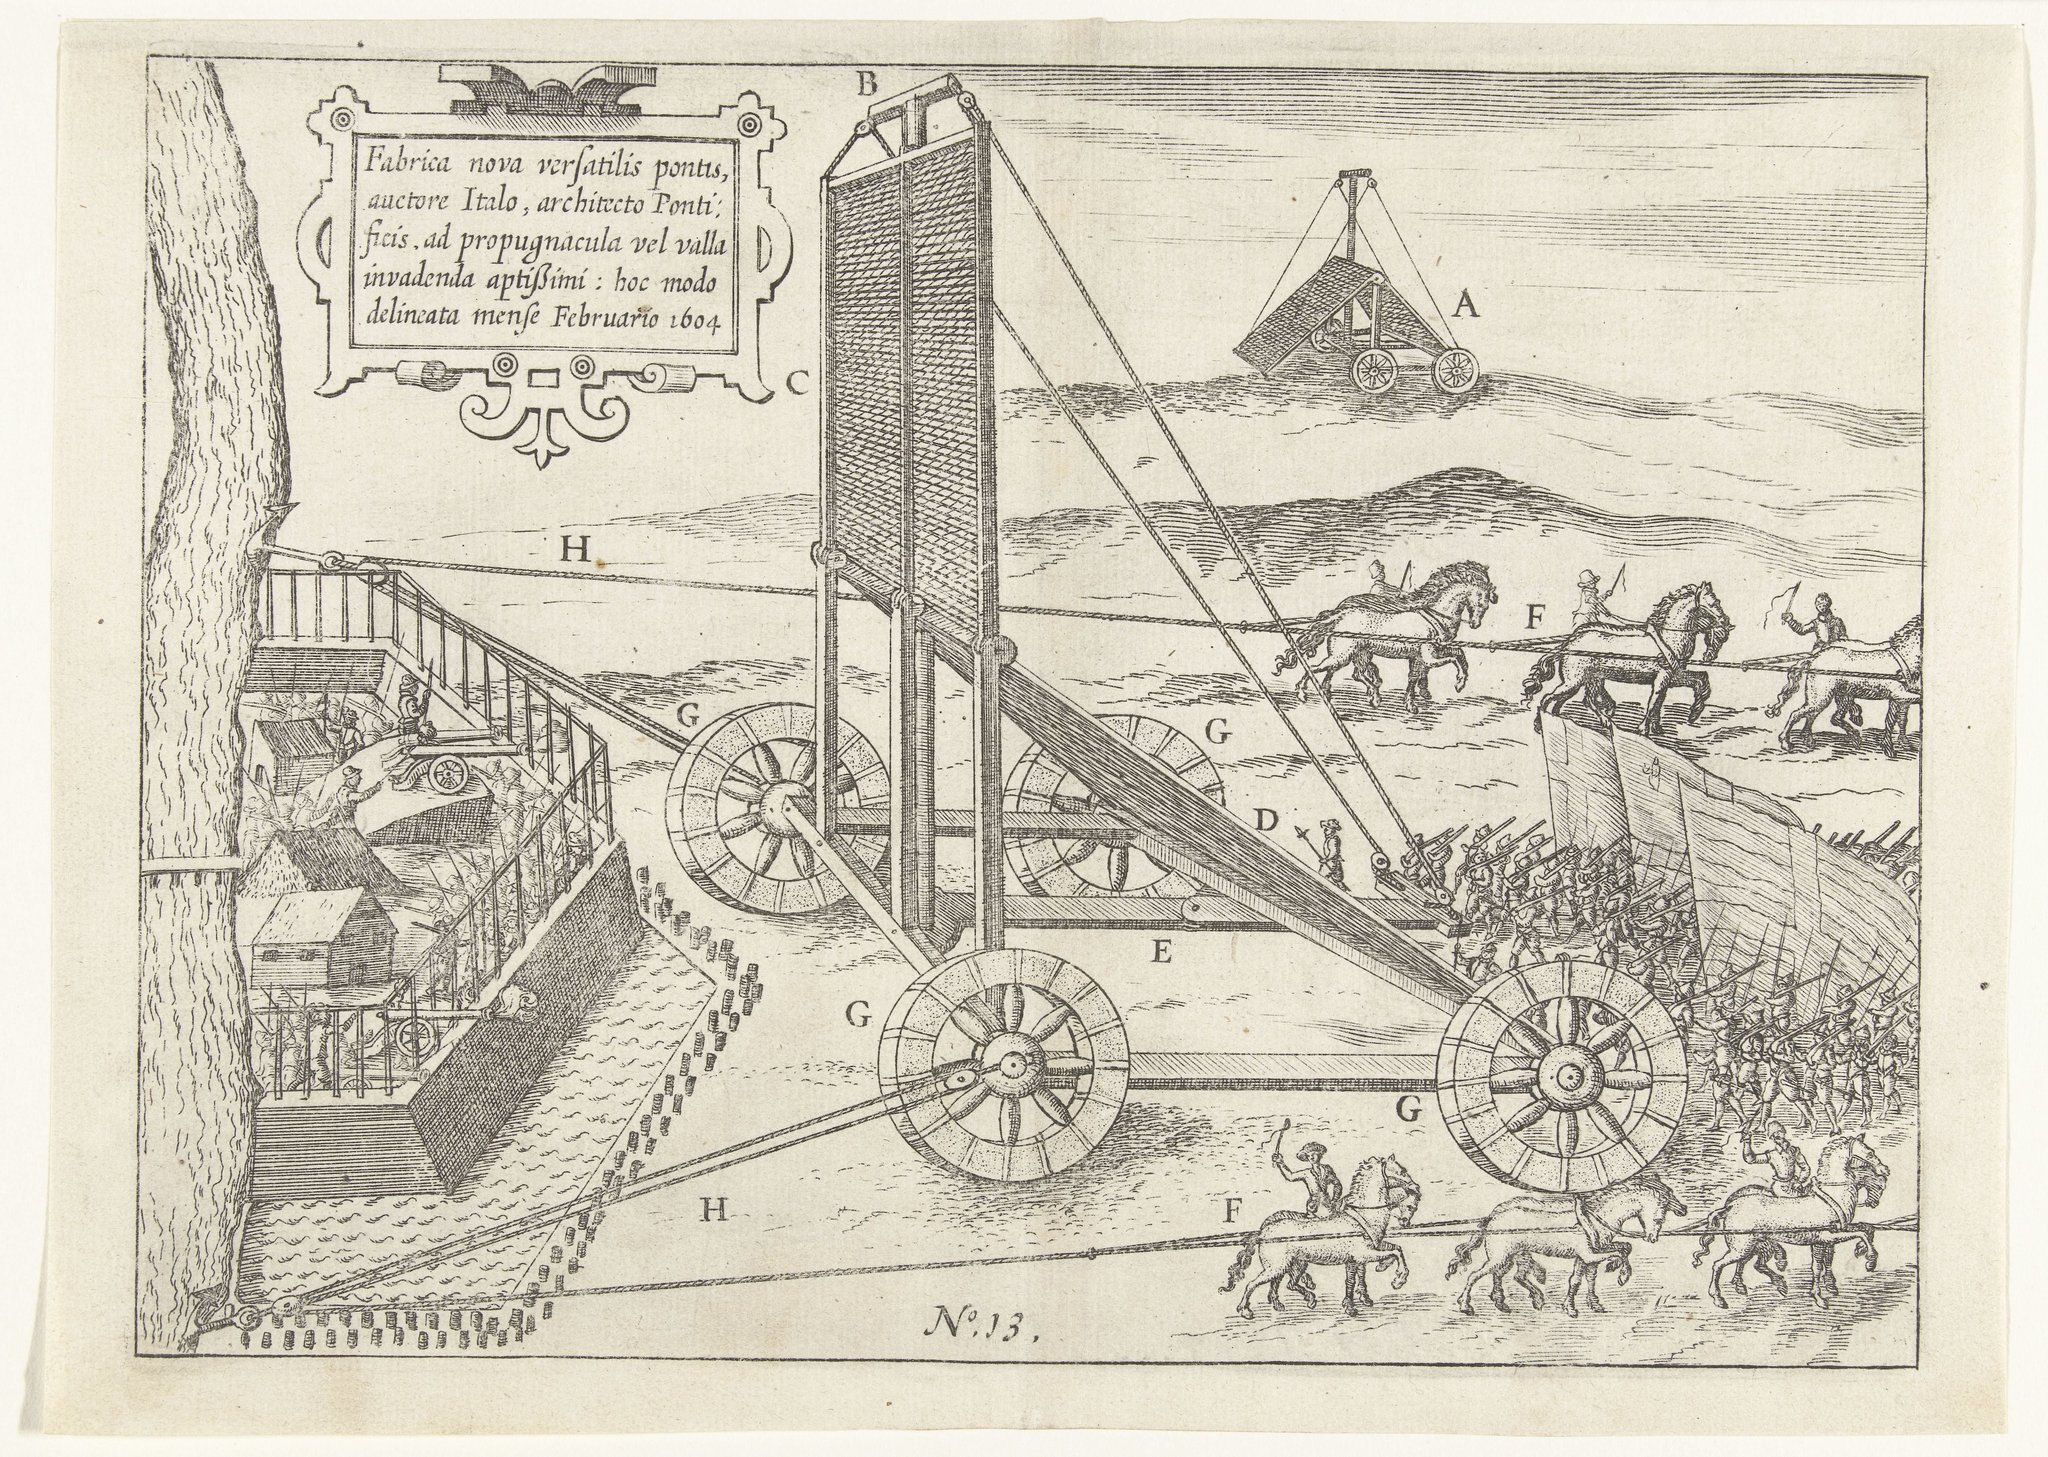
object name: print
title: Fabrica nova versatilis pontis, auctore Italo, architecto Ponti (...)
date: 1604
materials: paper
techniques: engraving, etching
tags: engineer, pompeo targone, siege, position war, siege arms, e.g.: battering ram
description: Eerst gebruikt in contemporaine journalen van het beleg van Oostende uit 1604 (exemplaren in de collectie van de Rijksmuseum Research Library (326 F 10 en 326 F 11). Later gebruikt in Haestens, Hendrick van. De Bloedige ende strenge Belegeringhe Der Stadt Oostende in Vlaenderen. Leiden: Hendrick van Haestens, 1613. In deze opgewerkte en hernummerde staat afkomstig uit de Franse uitgave: Haestens, Hendrick van. La nouvelle Troye ou memorable histoire du siege d’Ostende. Leiden: Hendrick van Haestens, 1615.